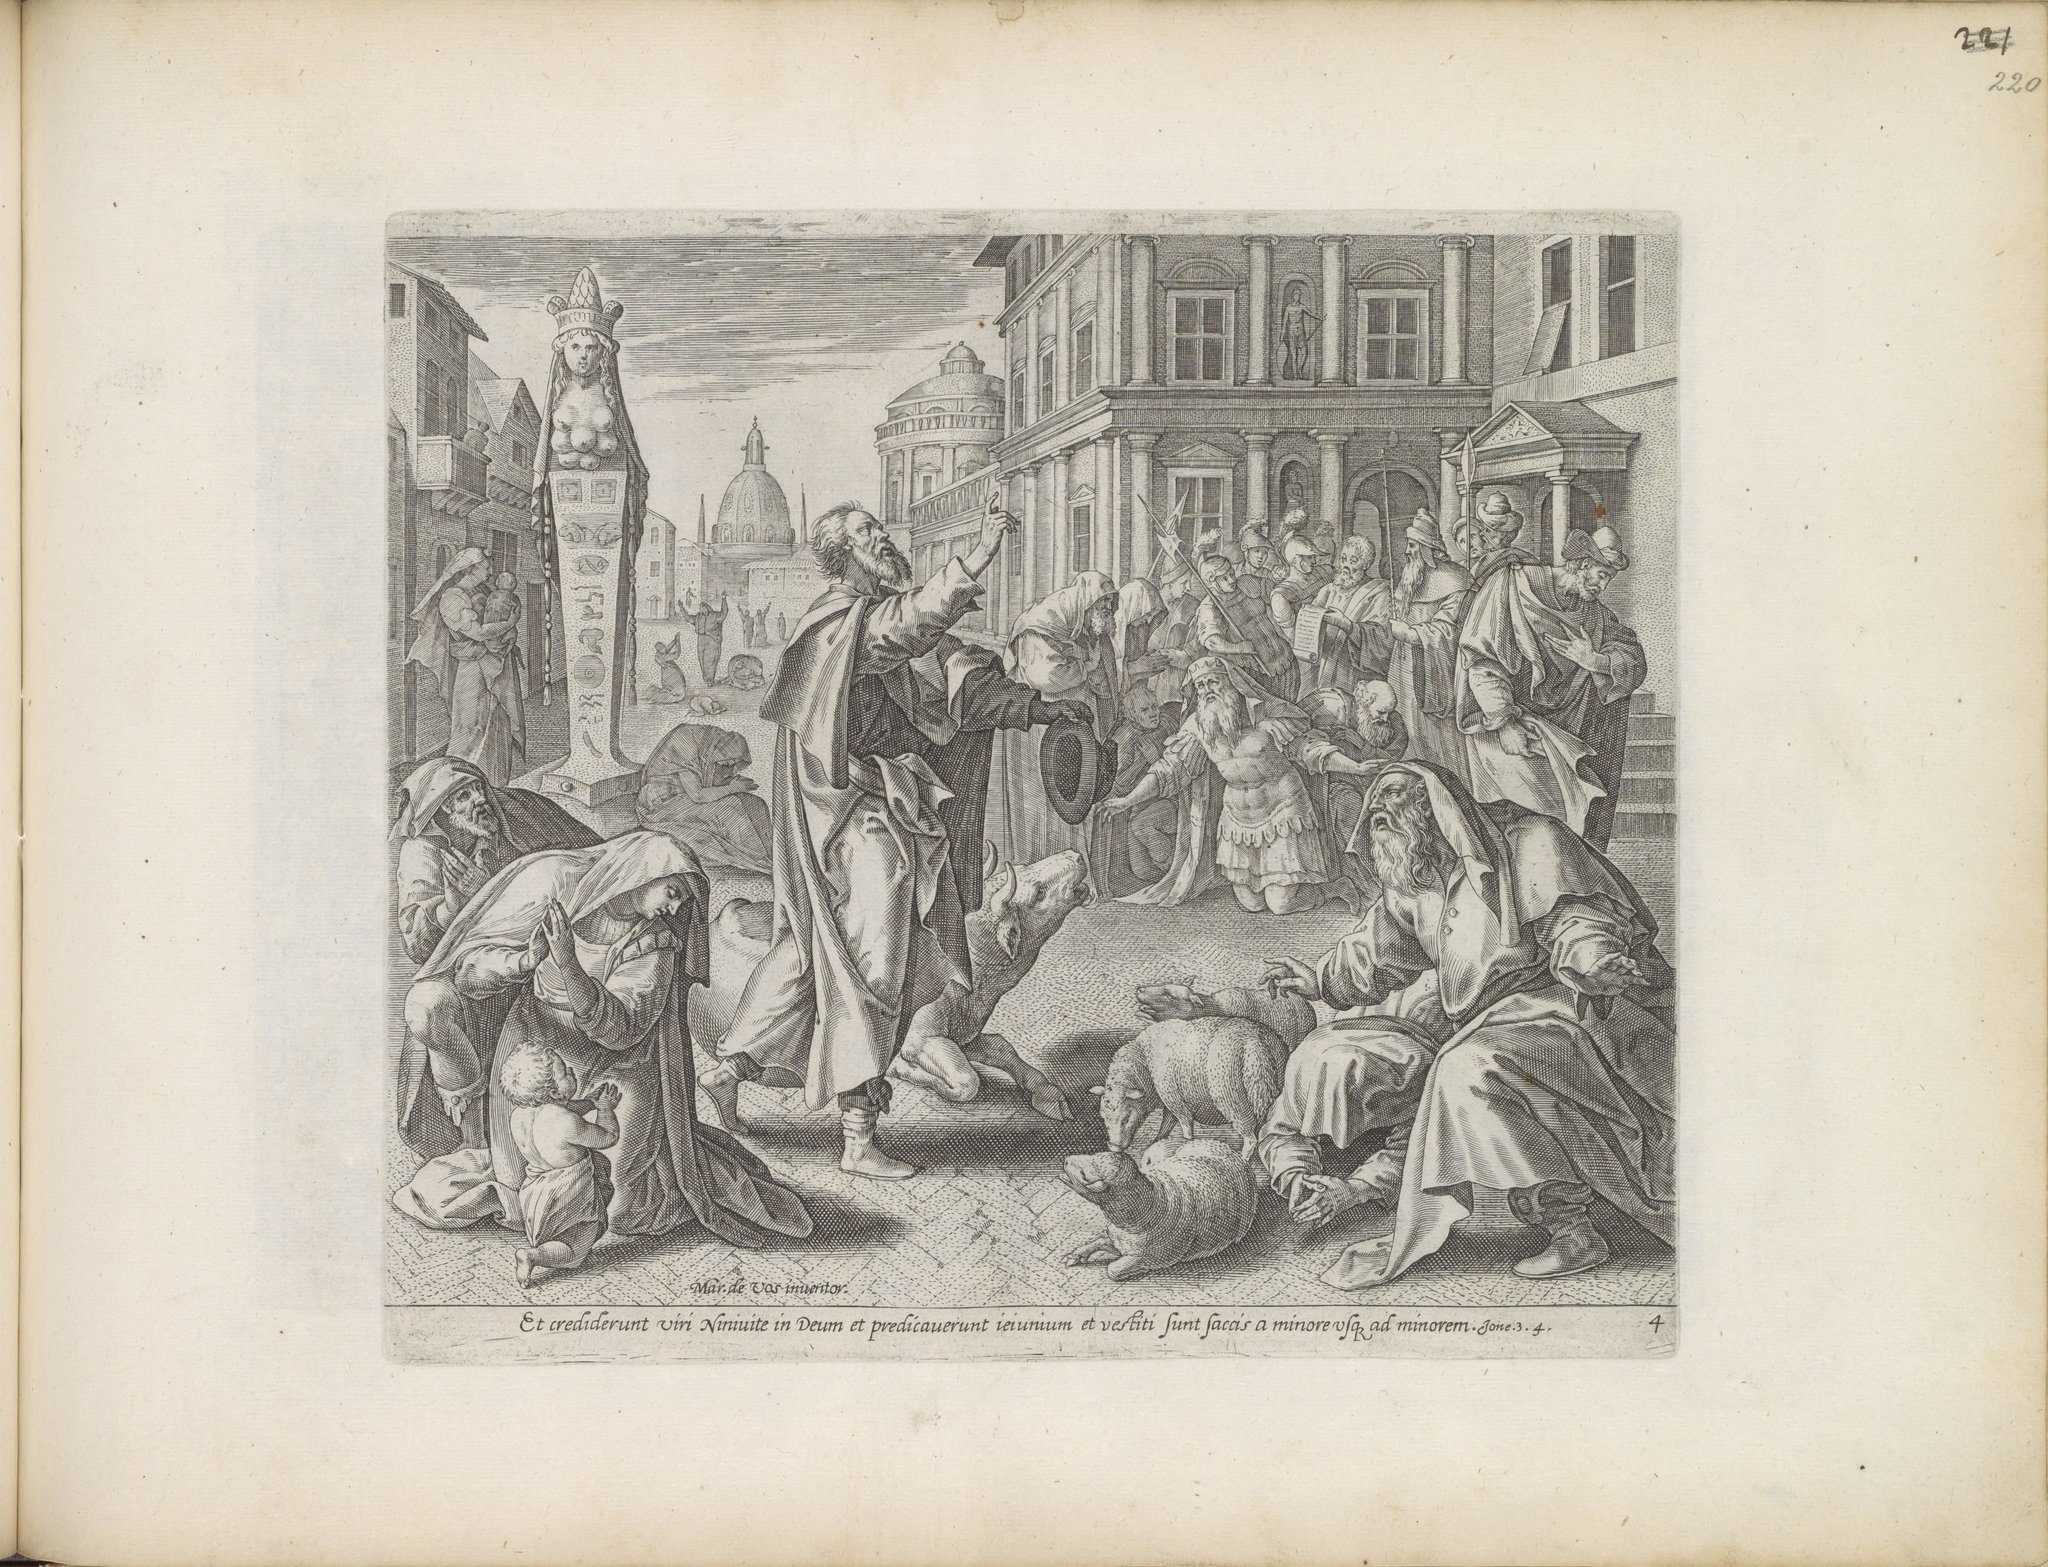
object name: album leaf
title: Theatrum Biblicum Hoc Est Historiae Sacrae Veteris et Novi Testamenti Tabulis Aeneis Expressae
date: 1570-1612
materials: paper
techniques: engraving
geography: amsterdam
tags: when the king of nineveh hears about the destruction of the city in forty days, he rises from his throne and decrees a general repentance for man and animal: all men, cattle and sheep must fast, people must wear sackcloth and pray to god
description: Jona bewandelt de straten van Nineve en verkondigt de ondergang van de stad vanwege afgoderij. De inwoners en de dieren van Nineve knielen op de grond en smeken God berouwvol om vergiffenis. Ook de koning werpt zich op de grond. Onder de voorstelling een verwijzing in het Latijn naar de Bijbeltekst in Jona 3:4. Deze prent maakt deel uit van een album.